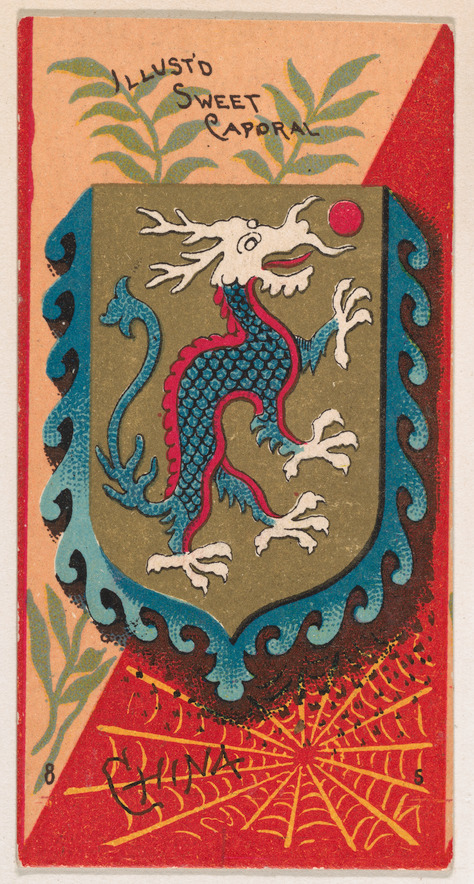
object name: print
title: Coat of Arms, China, from the Military Series (N224) issued by Kinney Tobacco Company to promote Sweet Caporal Cigarettes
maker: kinney brothers tobacco company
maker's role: publisher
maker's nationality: american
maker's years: 1869-2011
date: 1888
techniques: color lithograph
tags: dragons,leaves,coat of arms